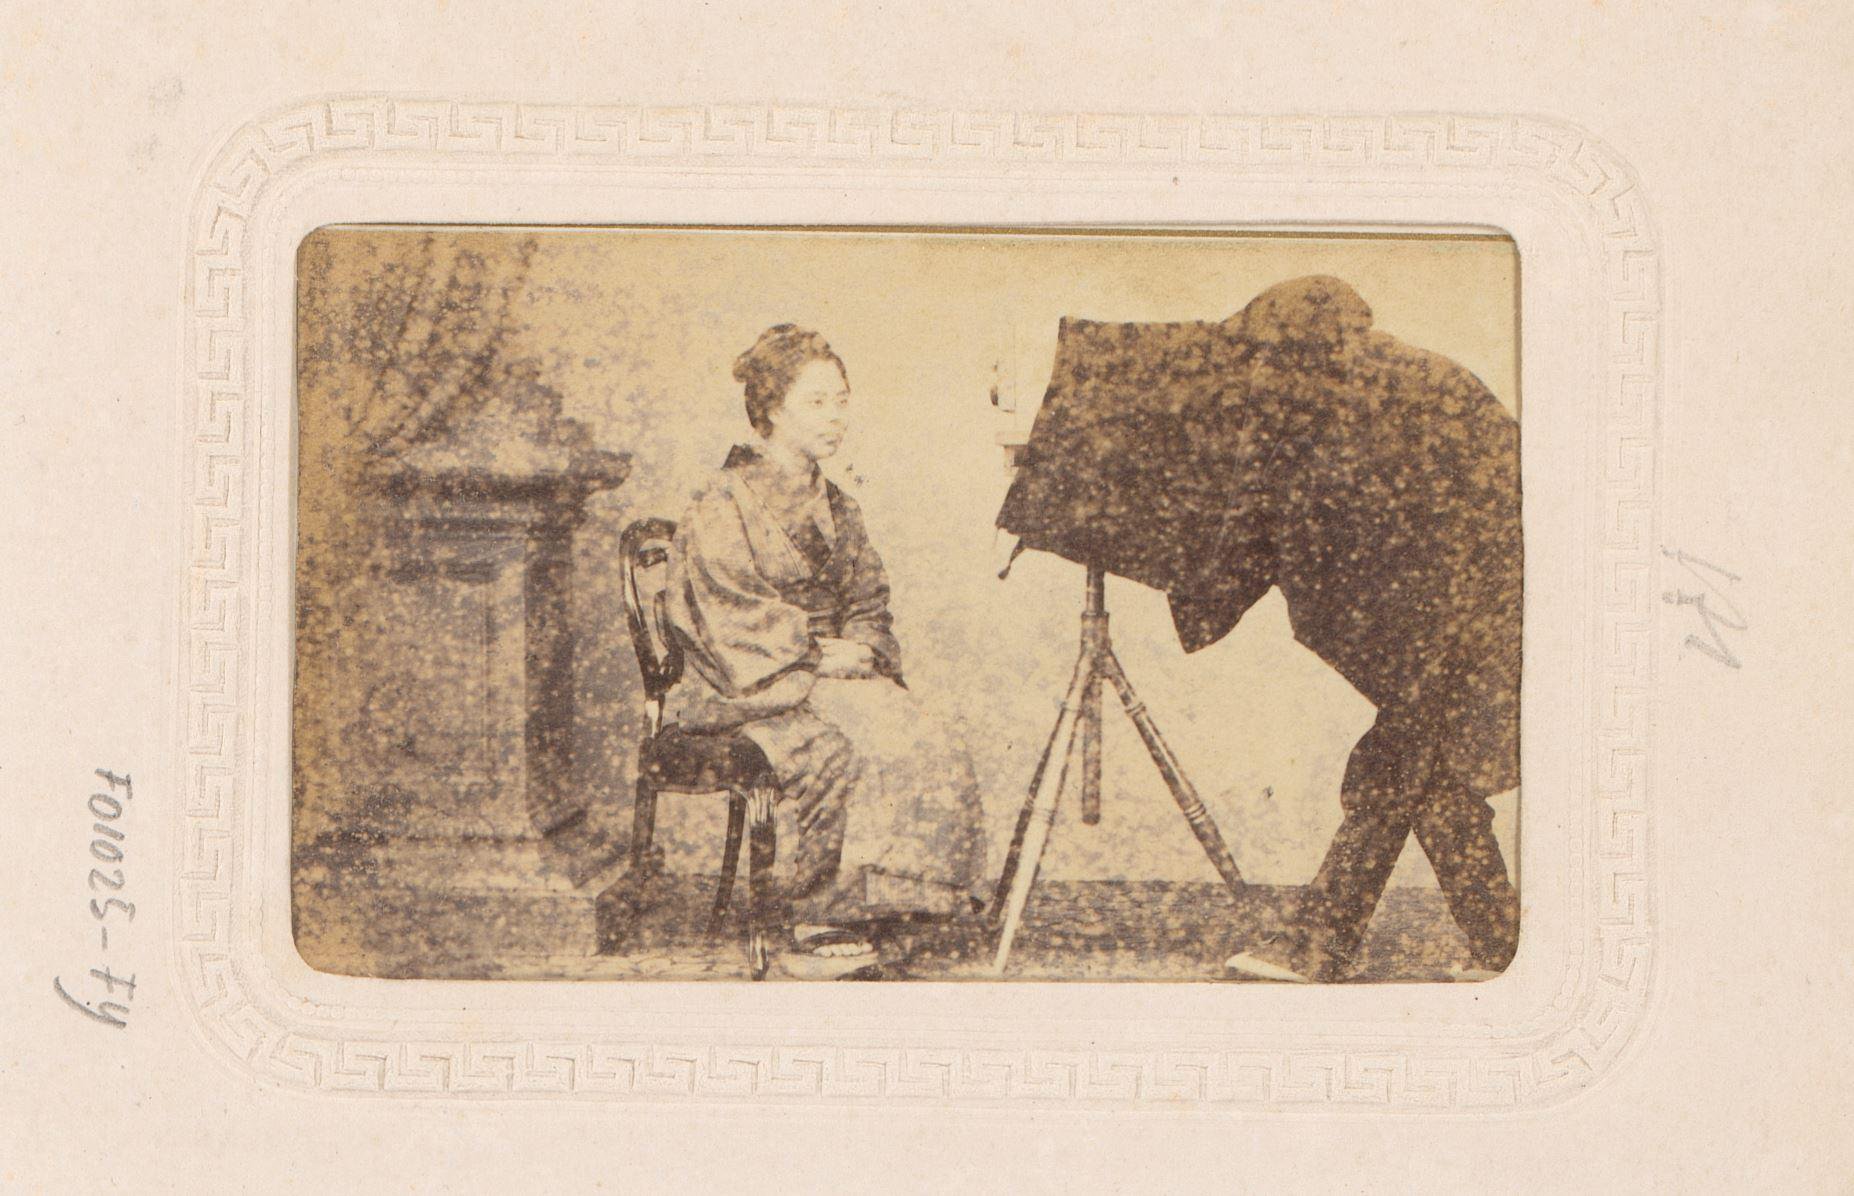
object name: album leaf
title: Japanse vrouw poseert voor een fotograaf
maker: Anonymous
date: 1850-1880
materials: cardboard, photographic support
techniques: albumen print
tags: adult woman, photographer at work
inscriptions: number: ‘181’